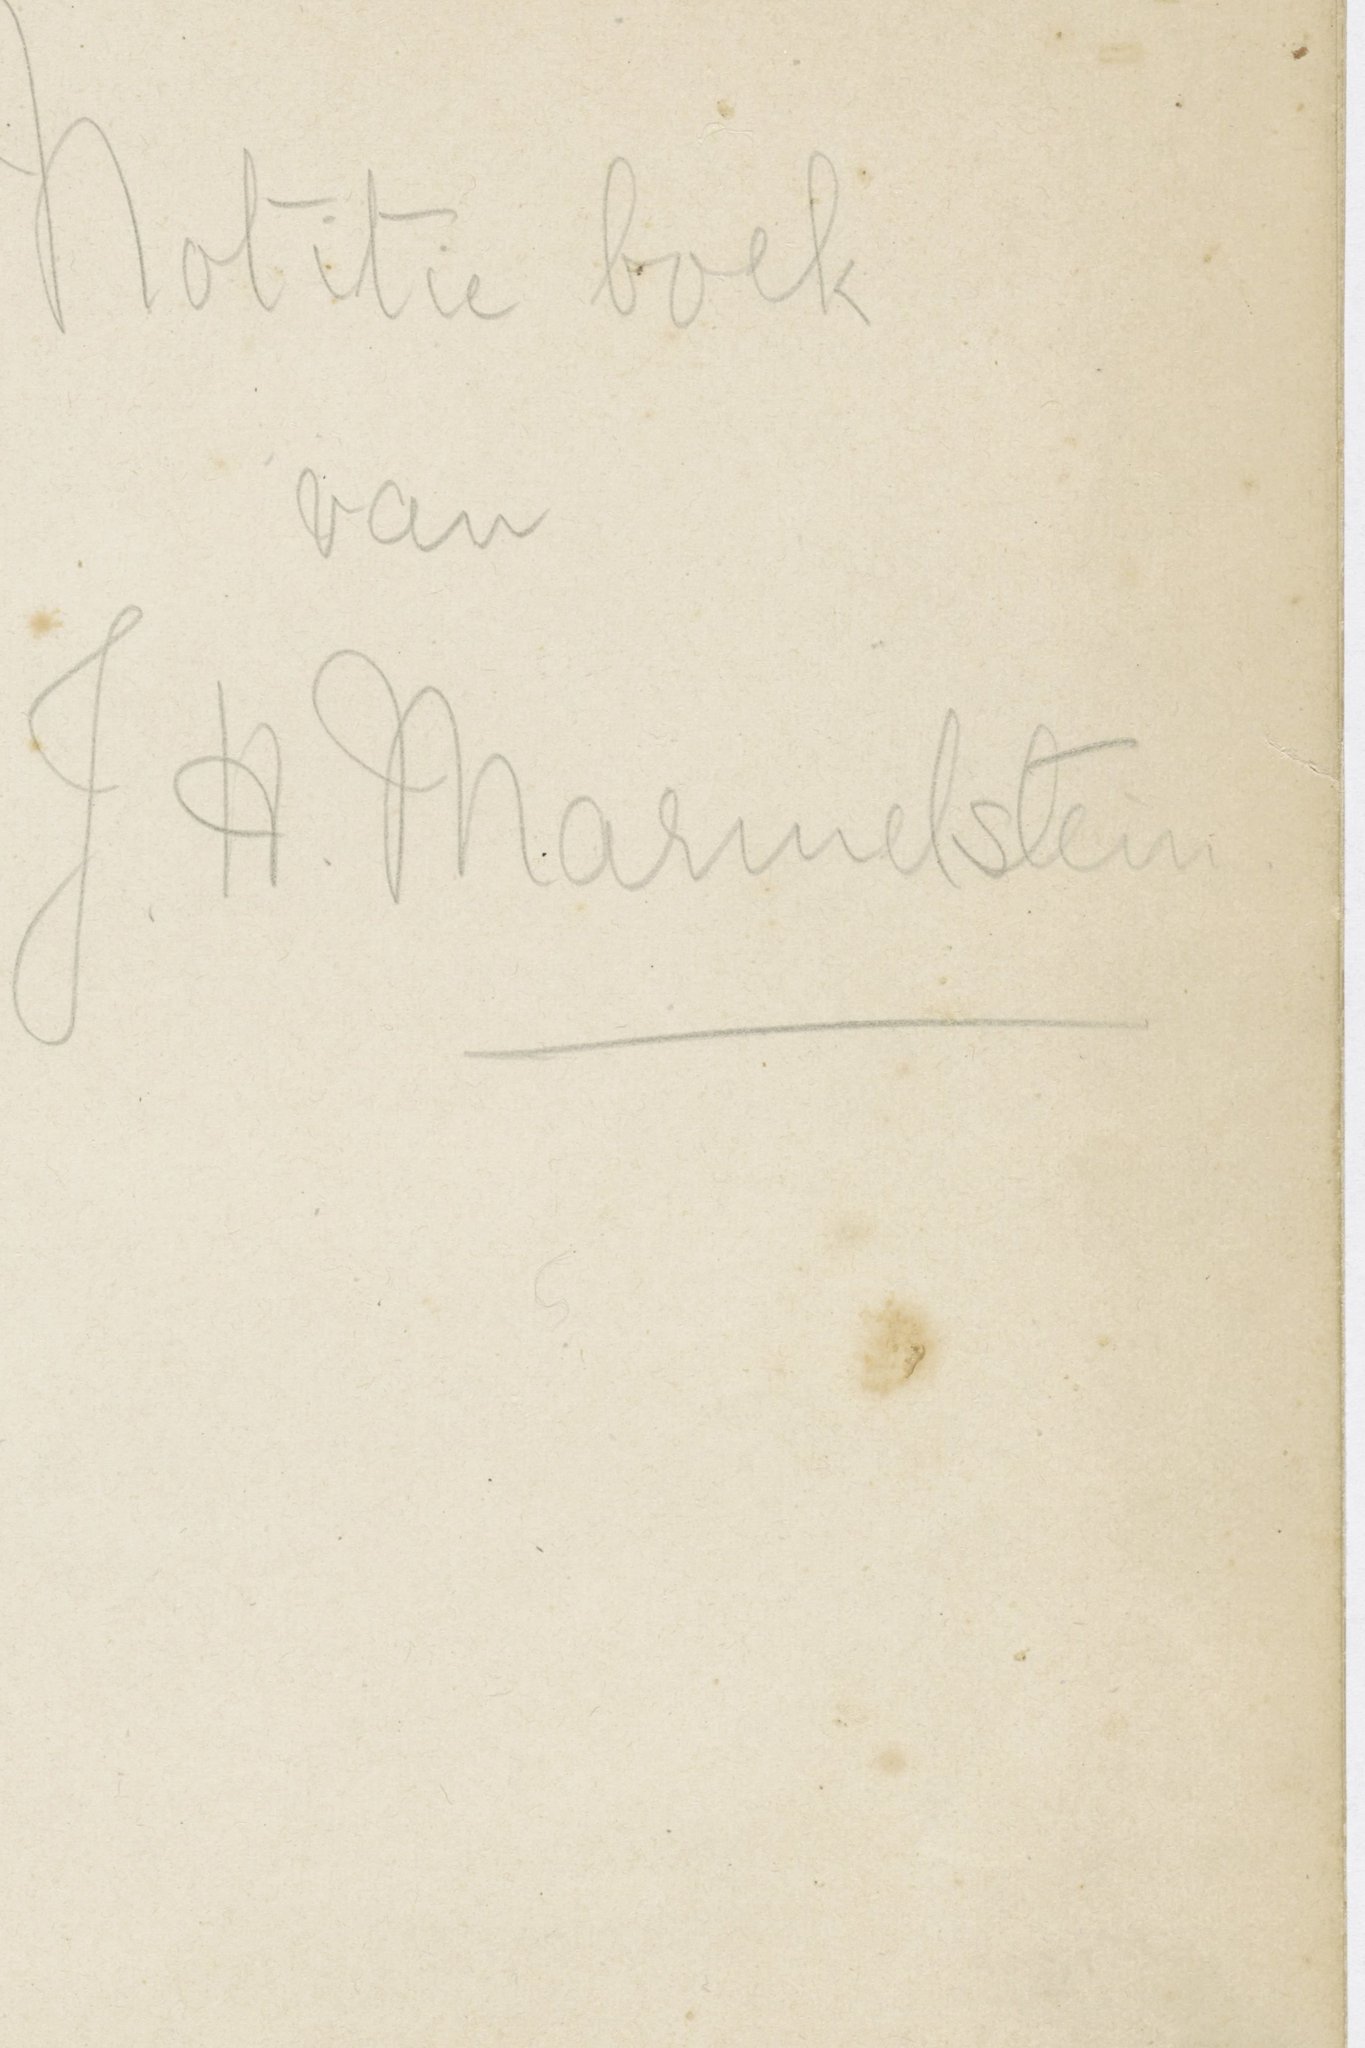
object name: photograph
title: Drie Javaanse kinderen in sarong spelen bij een waterstroom.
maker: neville keasberry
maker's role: fotograaf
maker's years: 1866-1944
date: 1900-1935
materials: cardboard, paper, photographic support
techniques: albumen print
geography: malang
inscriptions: inscription: ‘Stereoscopische Fotografie’, signature: ‘Neville Keasberry, Malang (Java)’